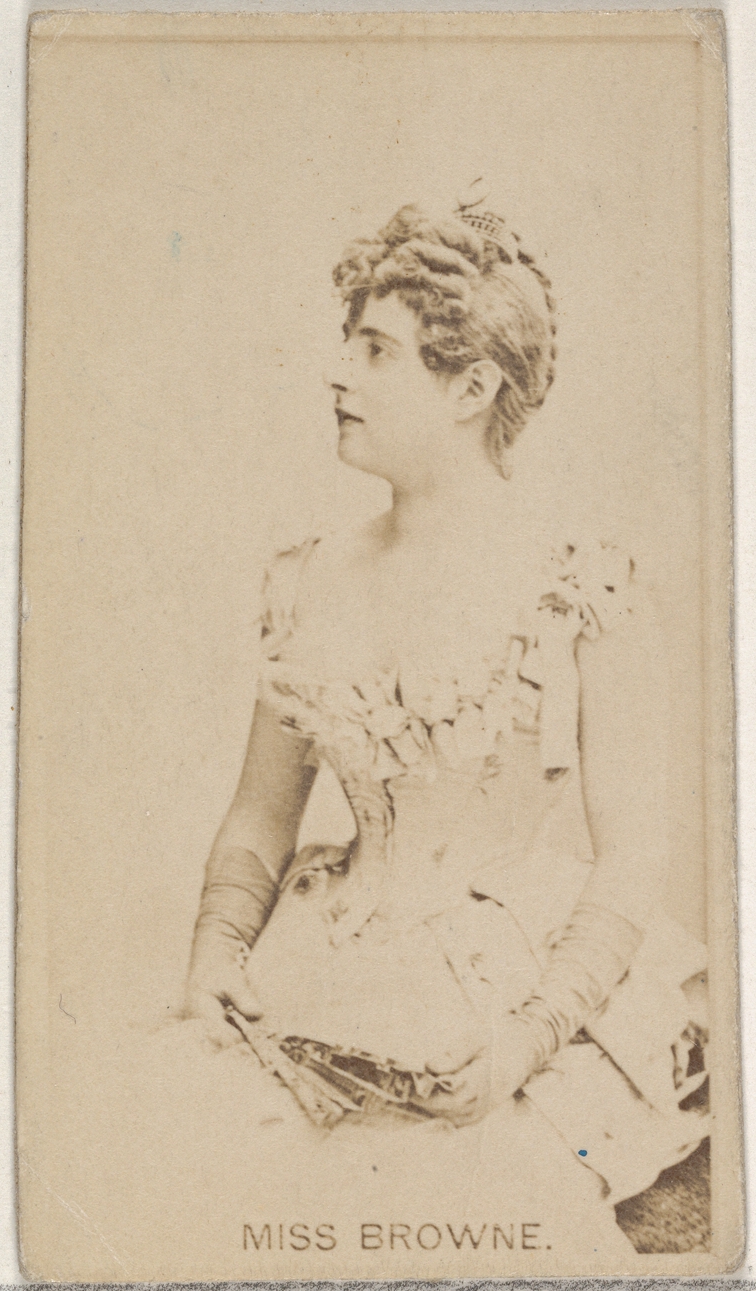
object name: photograph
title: Miss Browne, from the Actors and Actresses series (N45, Type 8) for Virginia Brights Cigarettes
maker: allen & ginter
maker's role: publisher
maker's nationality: american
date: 1888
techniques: albumen silver print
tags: portraits,women,actresses